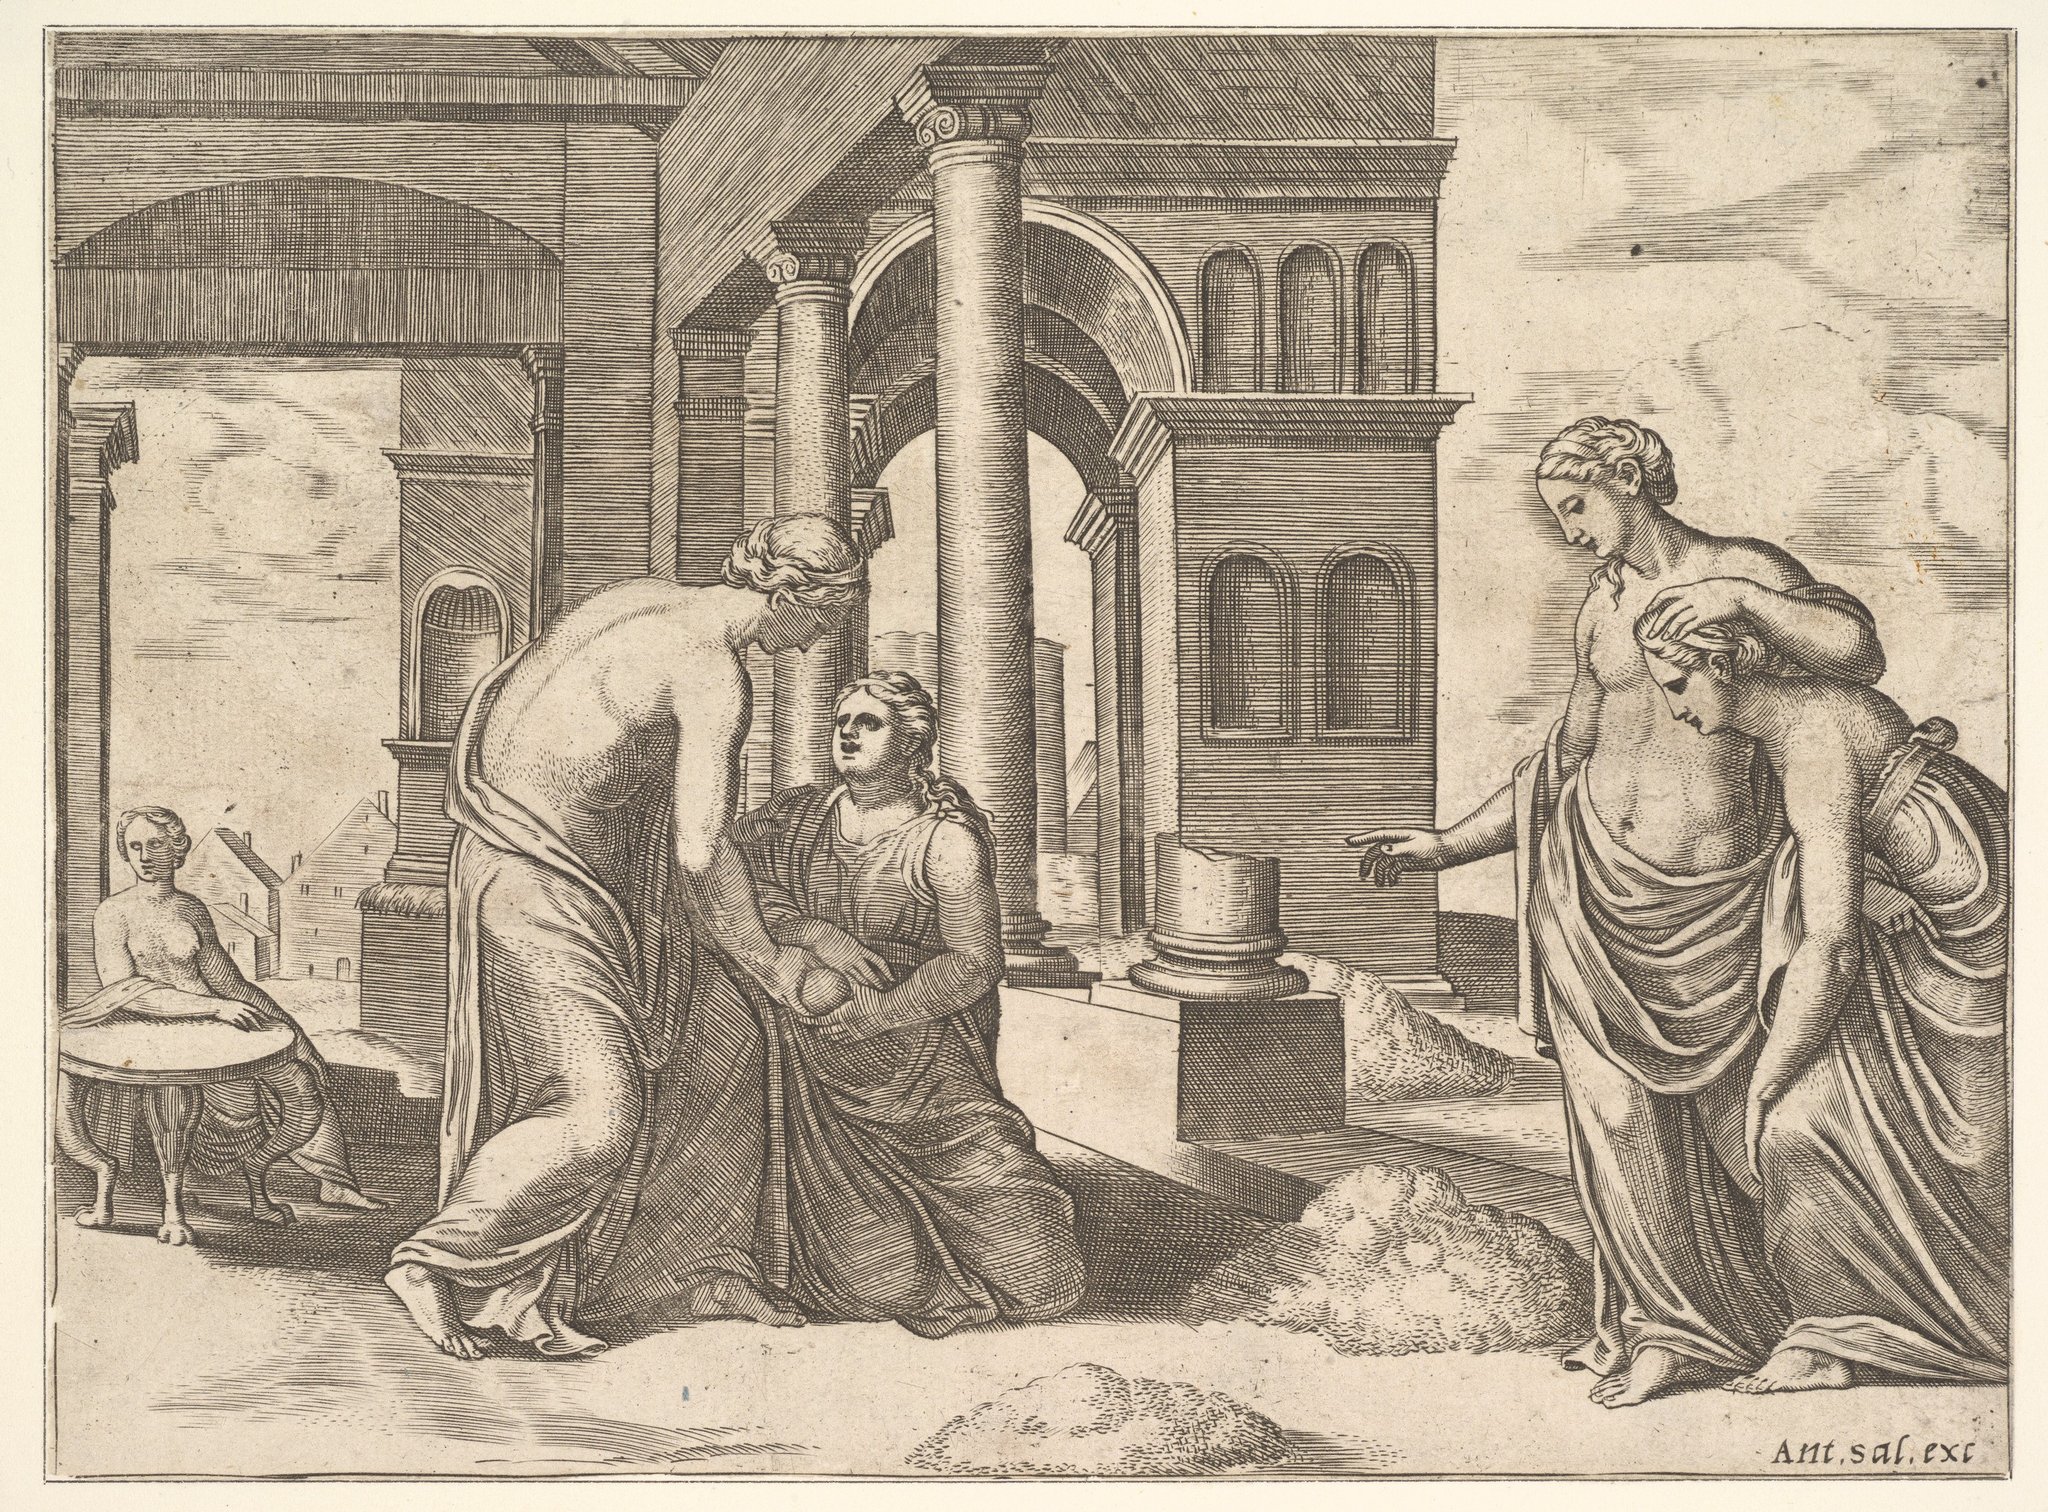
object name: print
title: Plate 22: Venus ordering Psyche to Sosort a heap of grain, from the 'Fable of Psyche'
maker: master of the die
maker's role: artist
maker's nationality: italian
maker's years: 1525-1560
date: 1530-1560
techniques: engraving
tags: psyche,venus